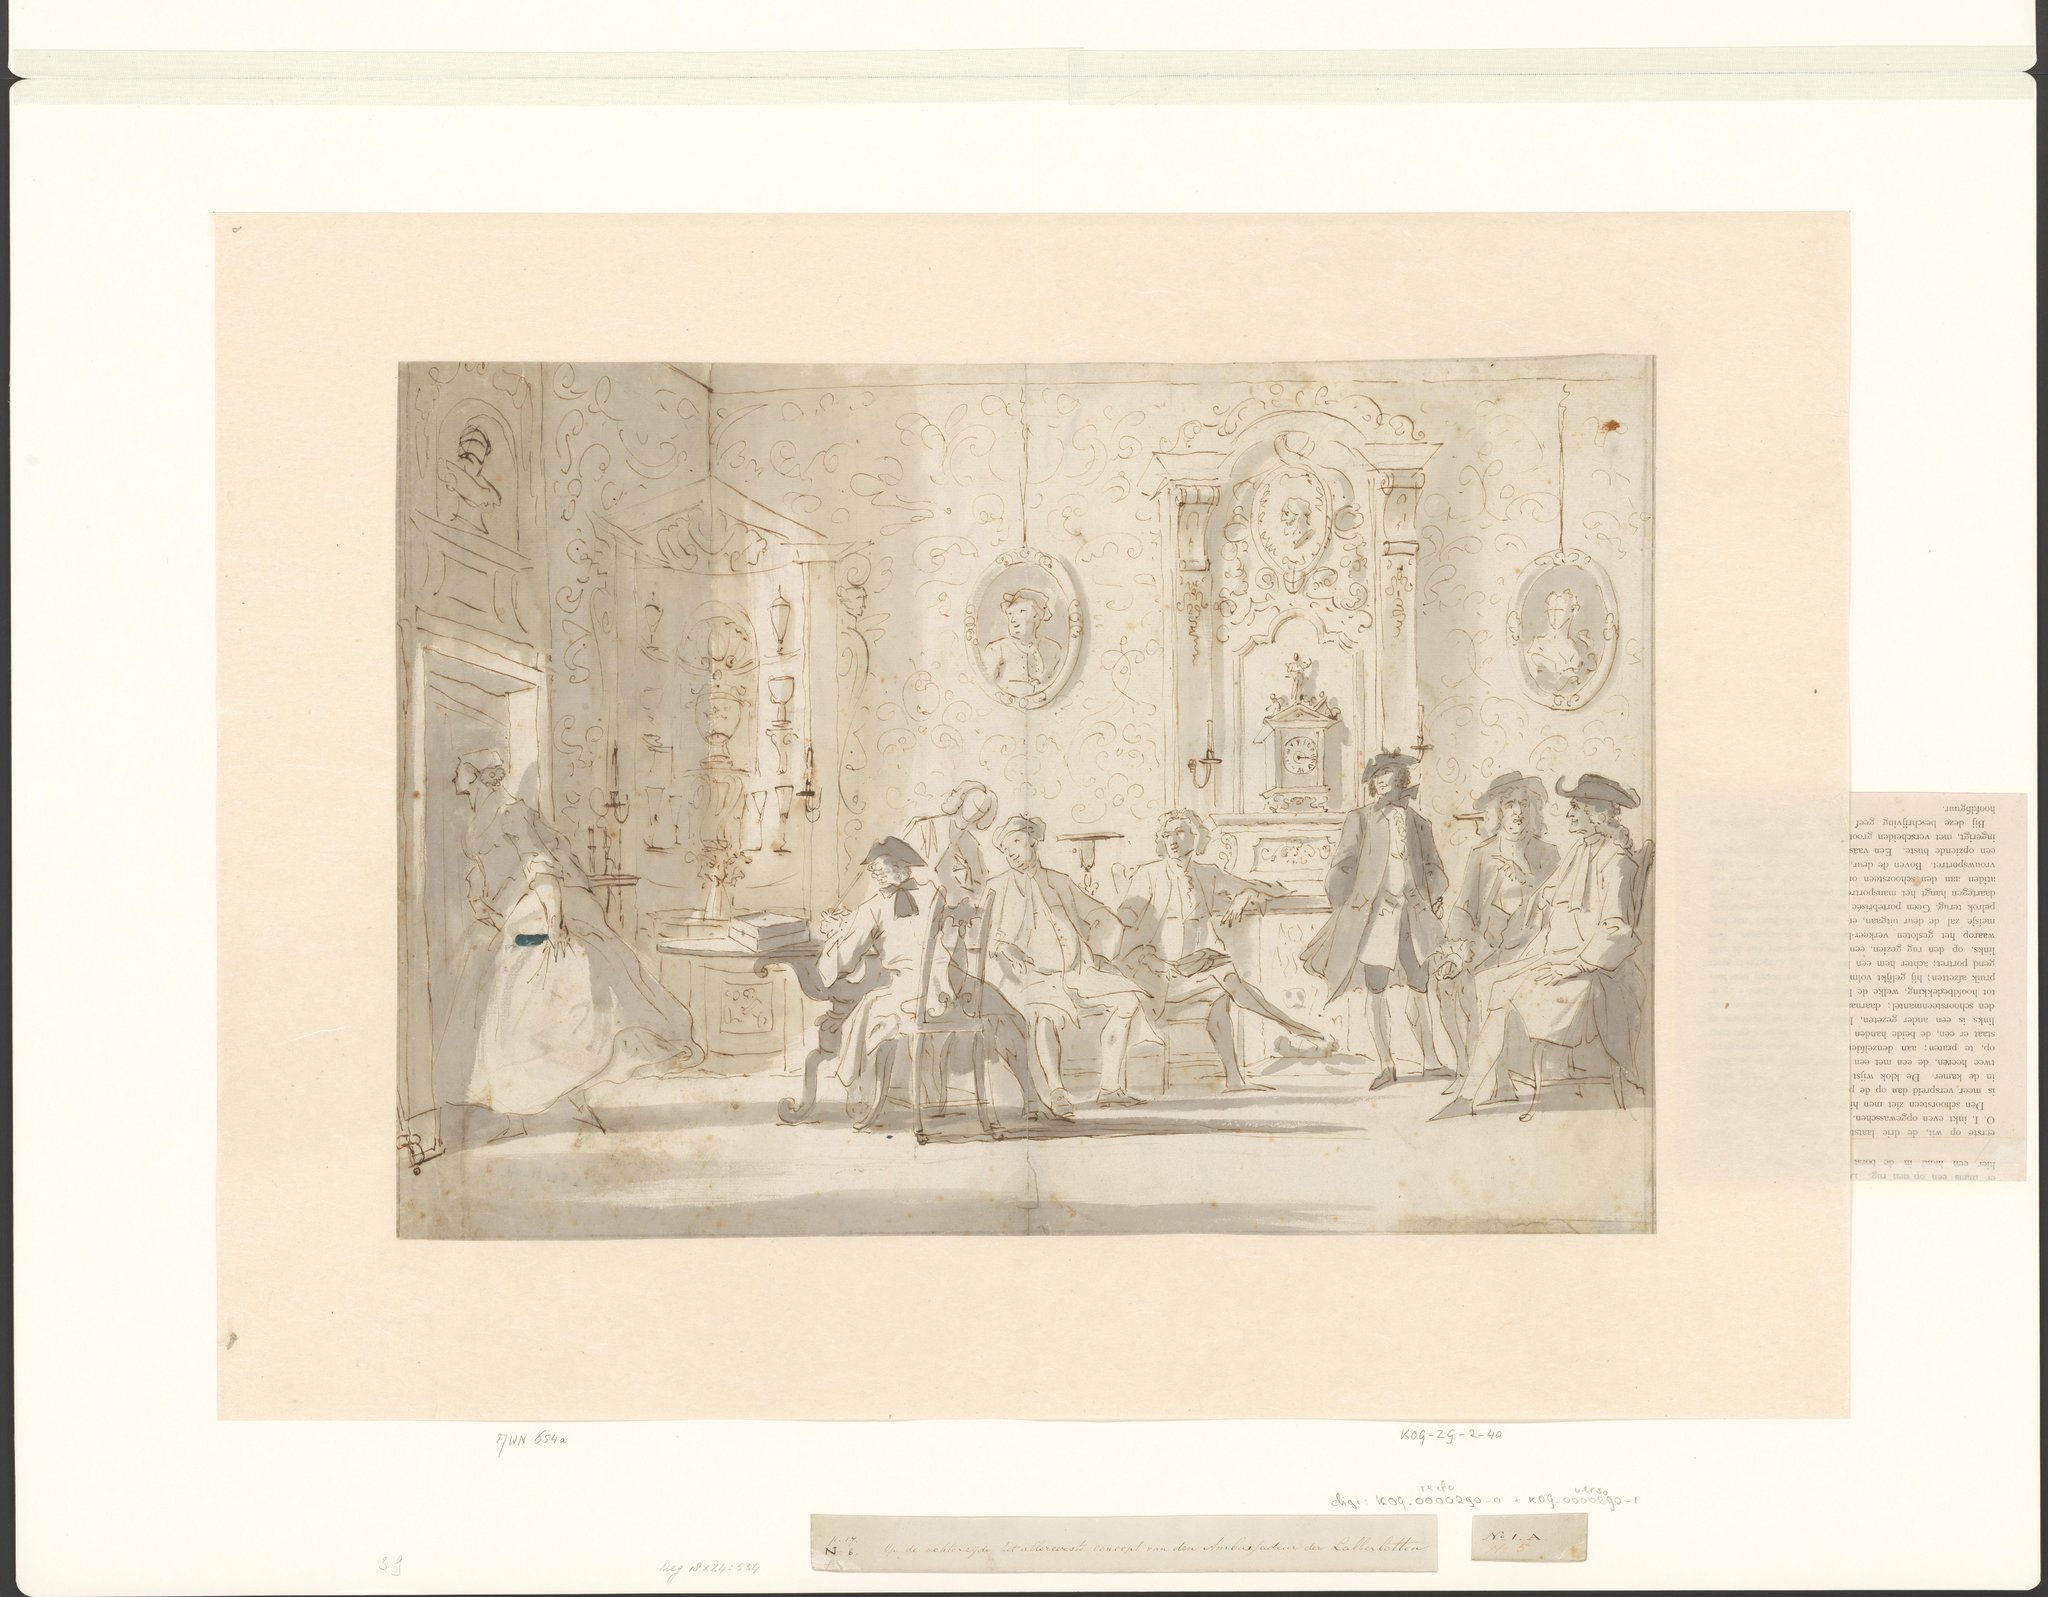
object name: drawing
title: Nelri-serie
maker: cornelis troost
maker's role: draughtsman, painter, print maker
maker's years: 1696-1750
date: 1739-1740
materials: ink, paper, pencil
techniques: brush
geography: netherlands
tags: criticizing and discussing art, art criticism, pipe ~ tobacco (+ taking (particular) foodstuffs: eating, drinking, smoking, chewing, etc.)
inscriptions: collector's mark: Lugt 2488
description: Samenkomst van heren in een interieur, ze zwijgen allen. Tweede voorstelling uit de Nelri-serie.